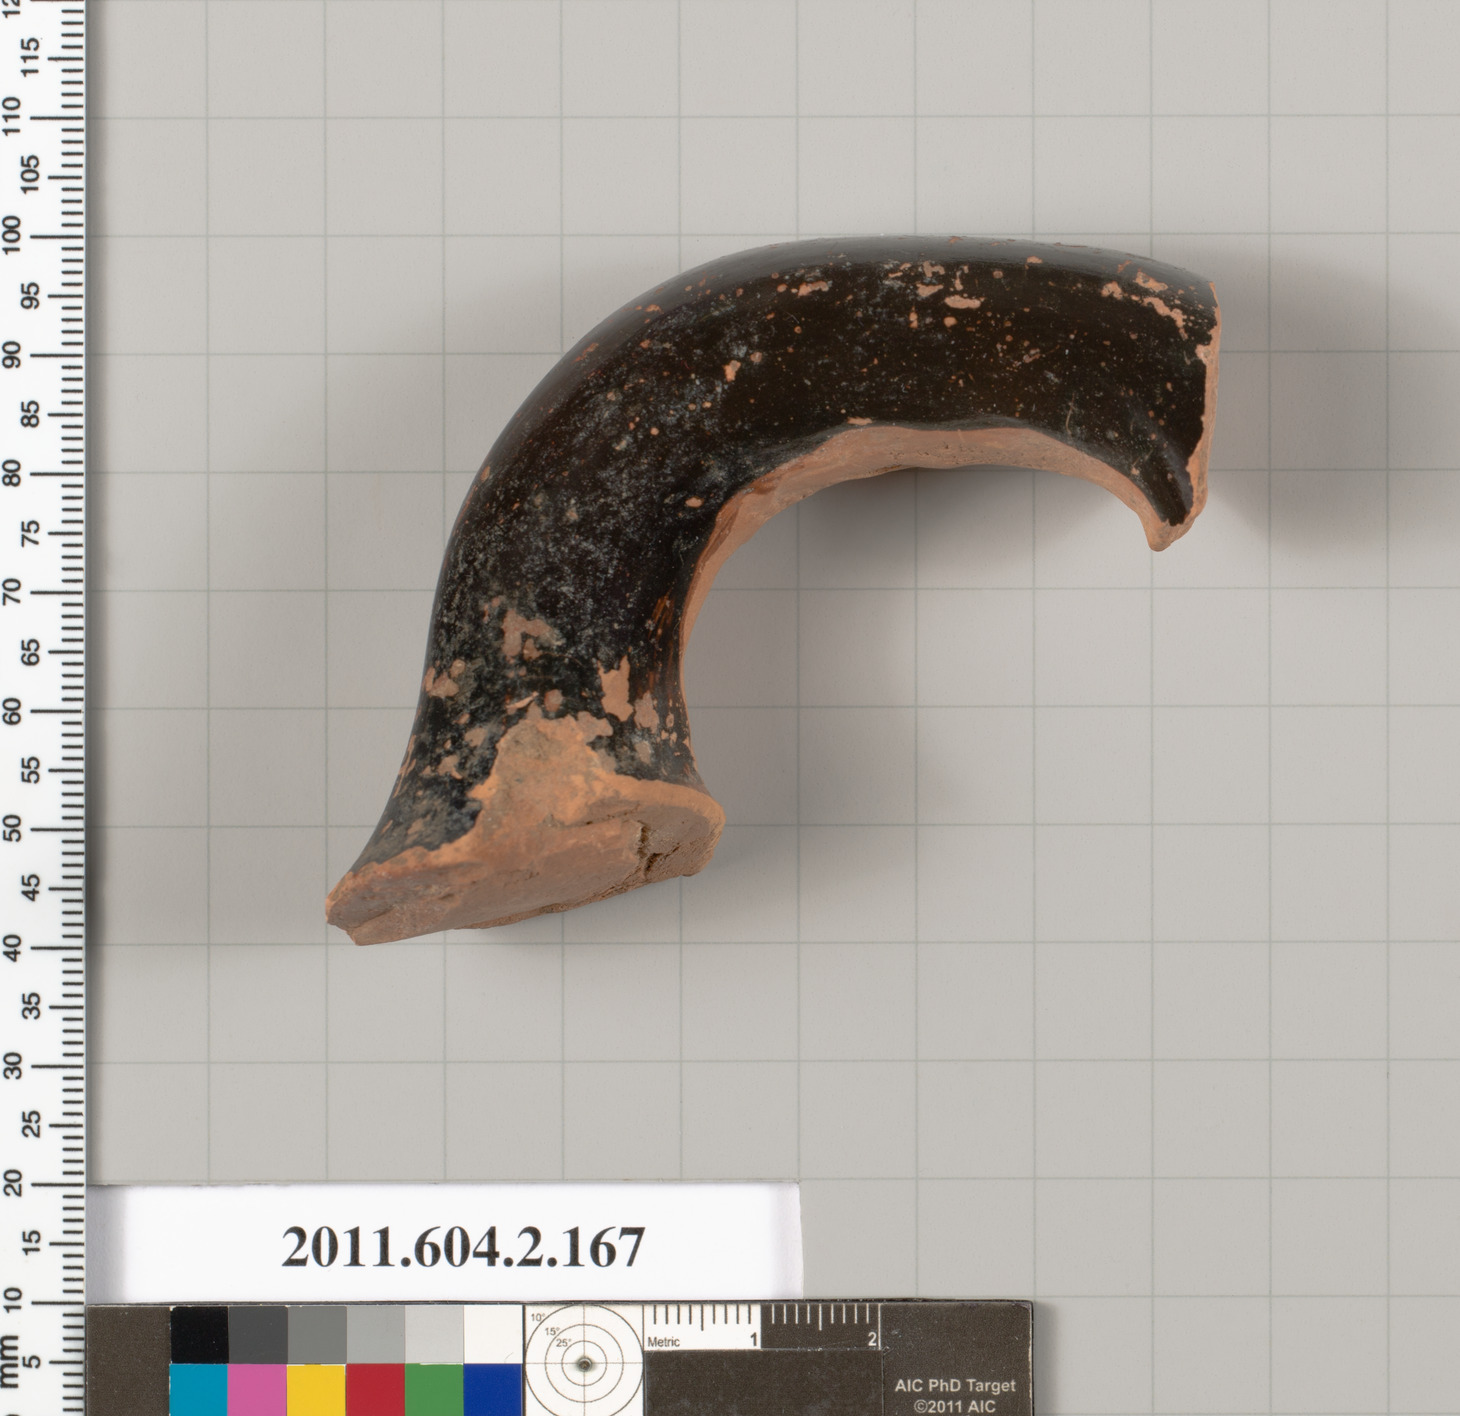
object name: stamnos fragment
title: Terracotta fragment of a stamnos (jar)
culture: greek, attic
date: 470-450 BCE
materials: terracotta